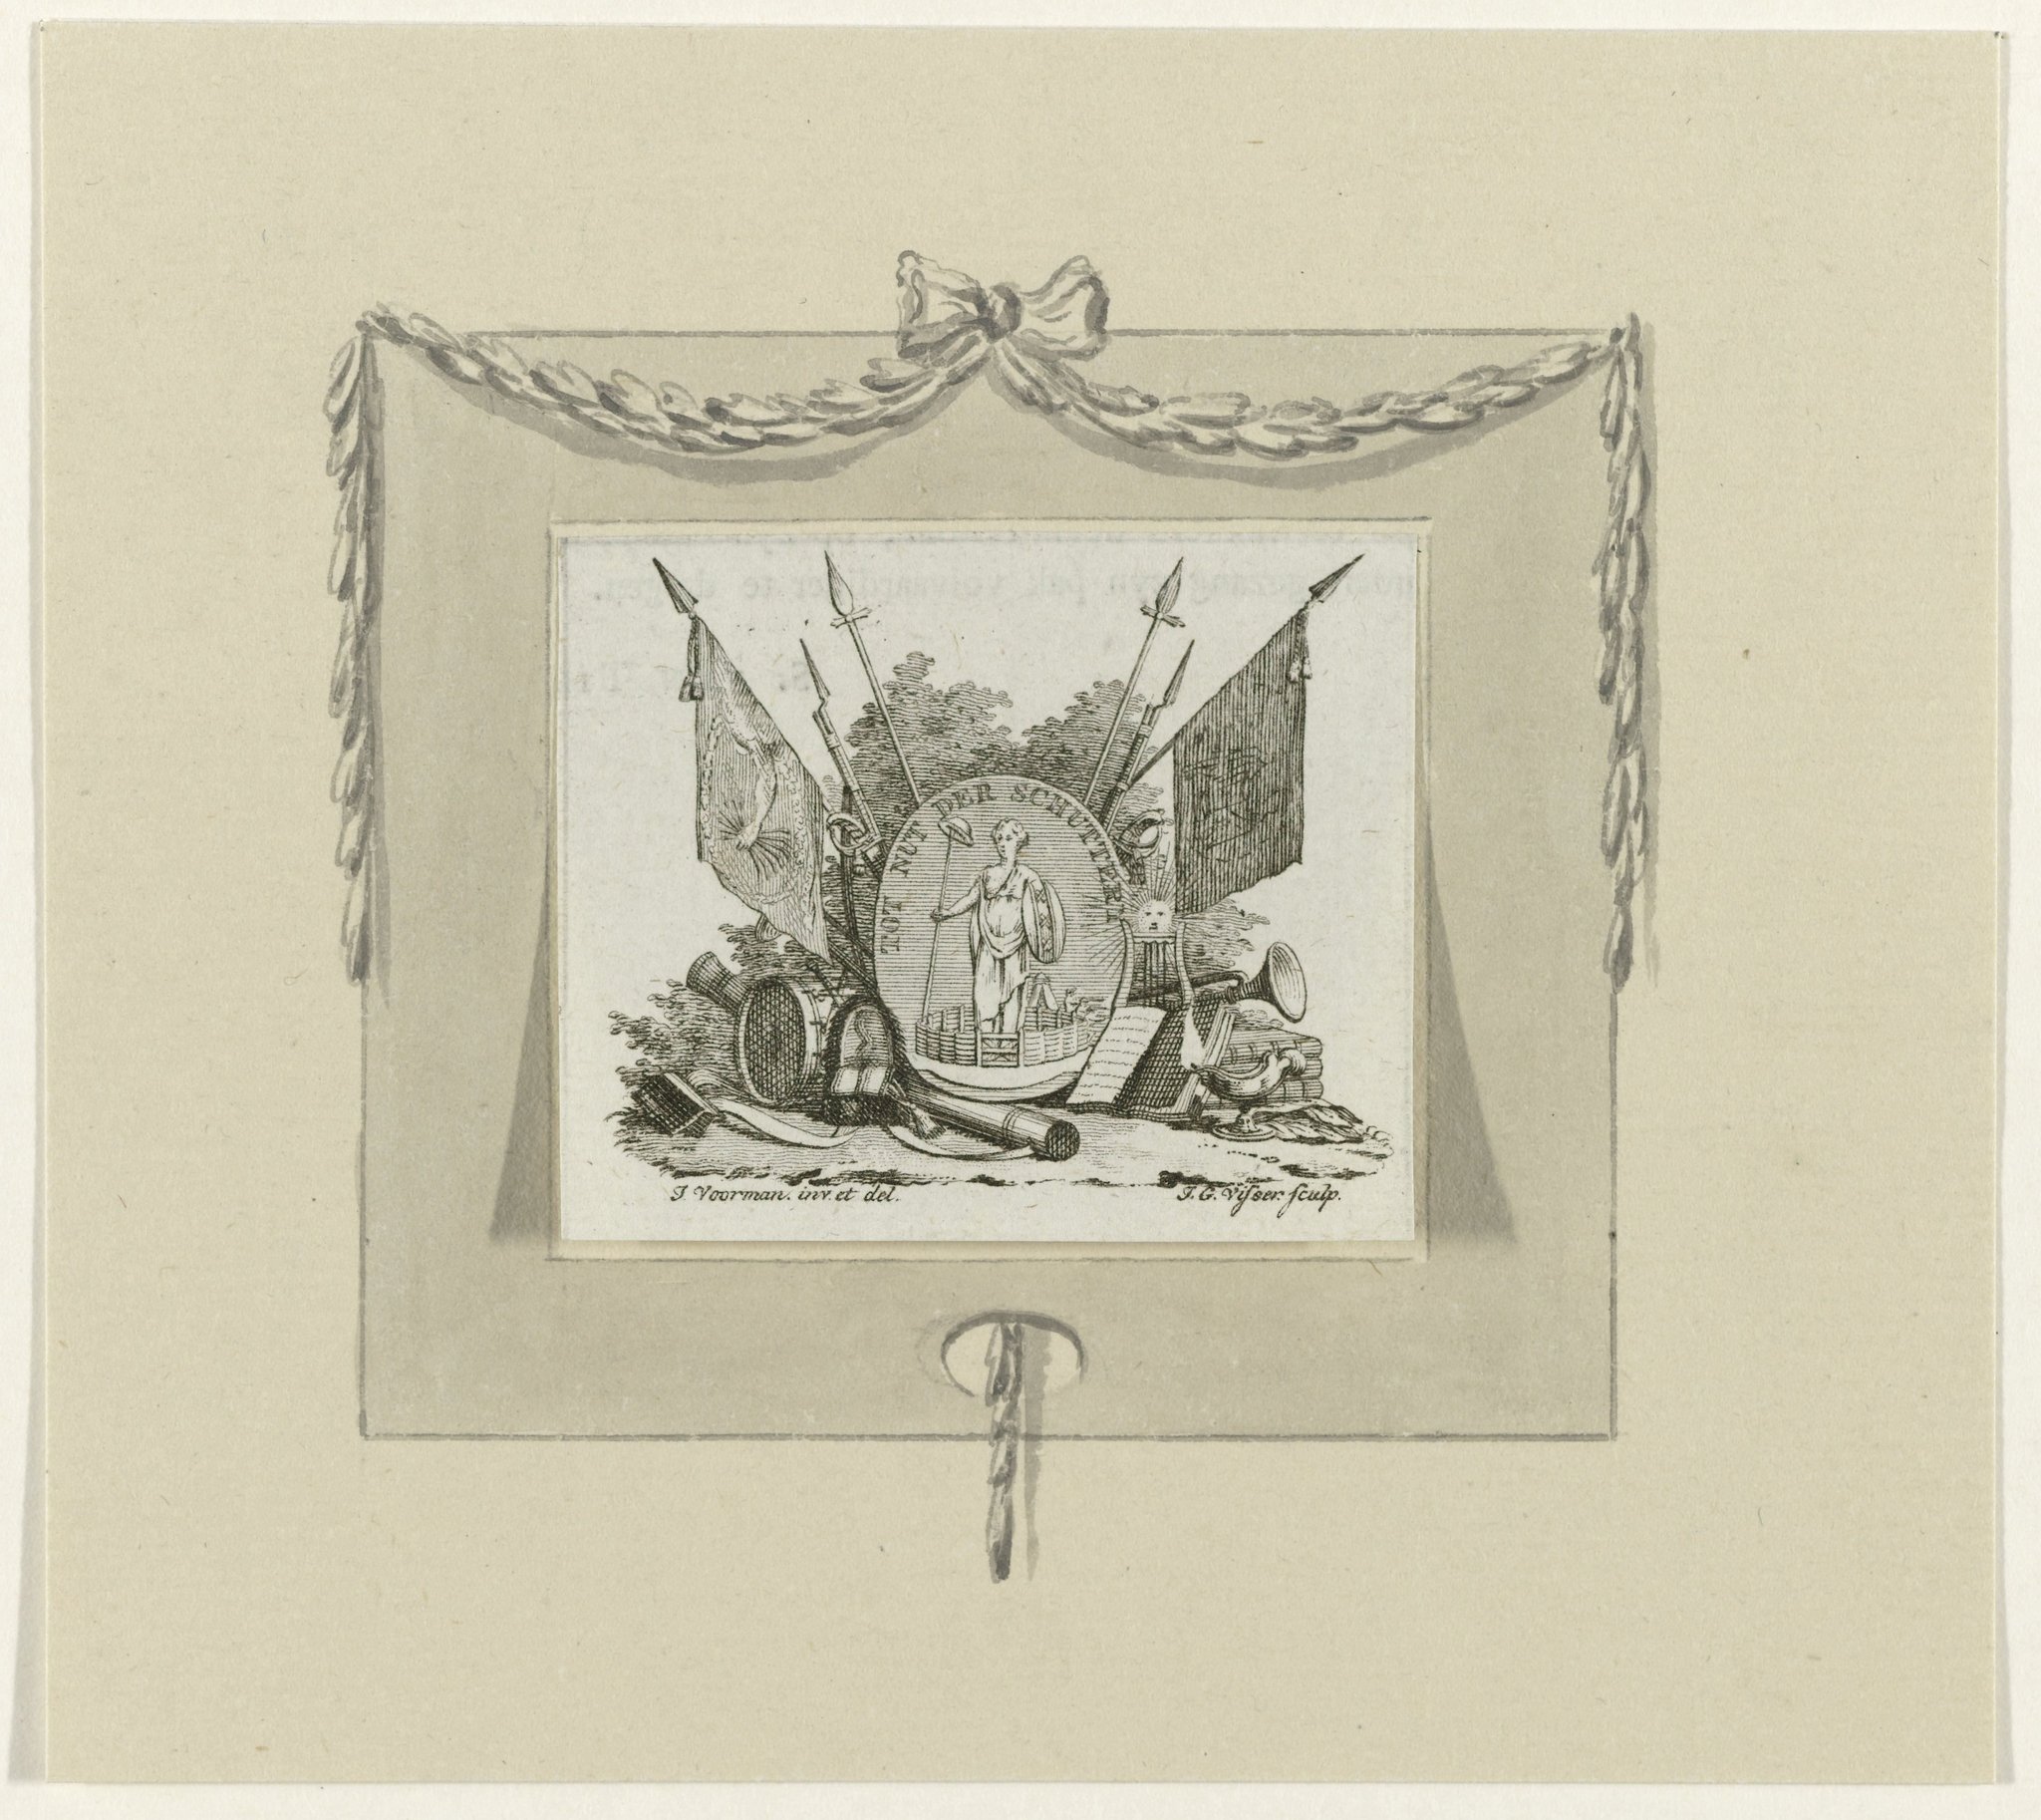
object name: print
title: Vignet met het embleem van het exercitiegenootschap Tot Nut der Schuttery, 1786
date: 1786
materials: paper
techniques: brush, engraving, etching, pen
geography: northern netherlands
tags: amsterdam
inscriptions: collector's mark: Lugt 2228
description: Niet in Frederik Muller; door het RPK toegevoegd nummer. Gebruikt als illustratie in: Jan Voorman. Bataafsche gezangen, voor het wapenöeffenend genootschap, onder de spreuk: Tot nut der schuttery, te Amsterdam. Amsterdam: Jan Verlem, 1786.